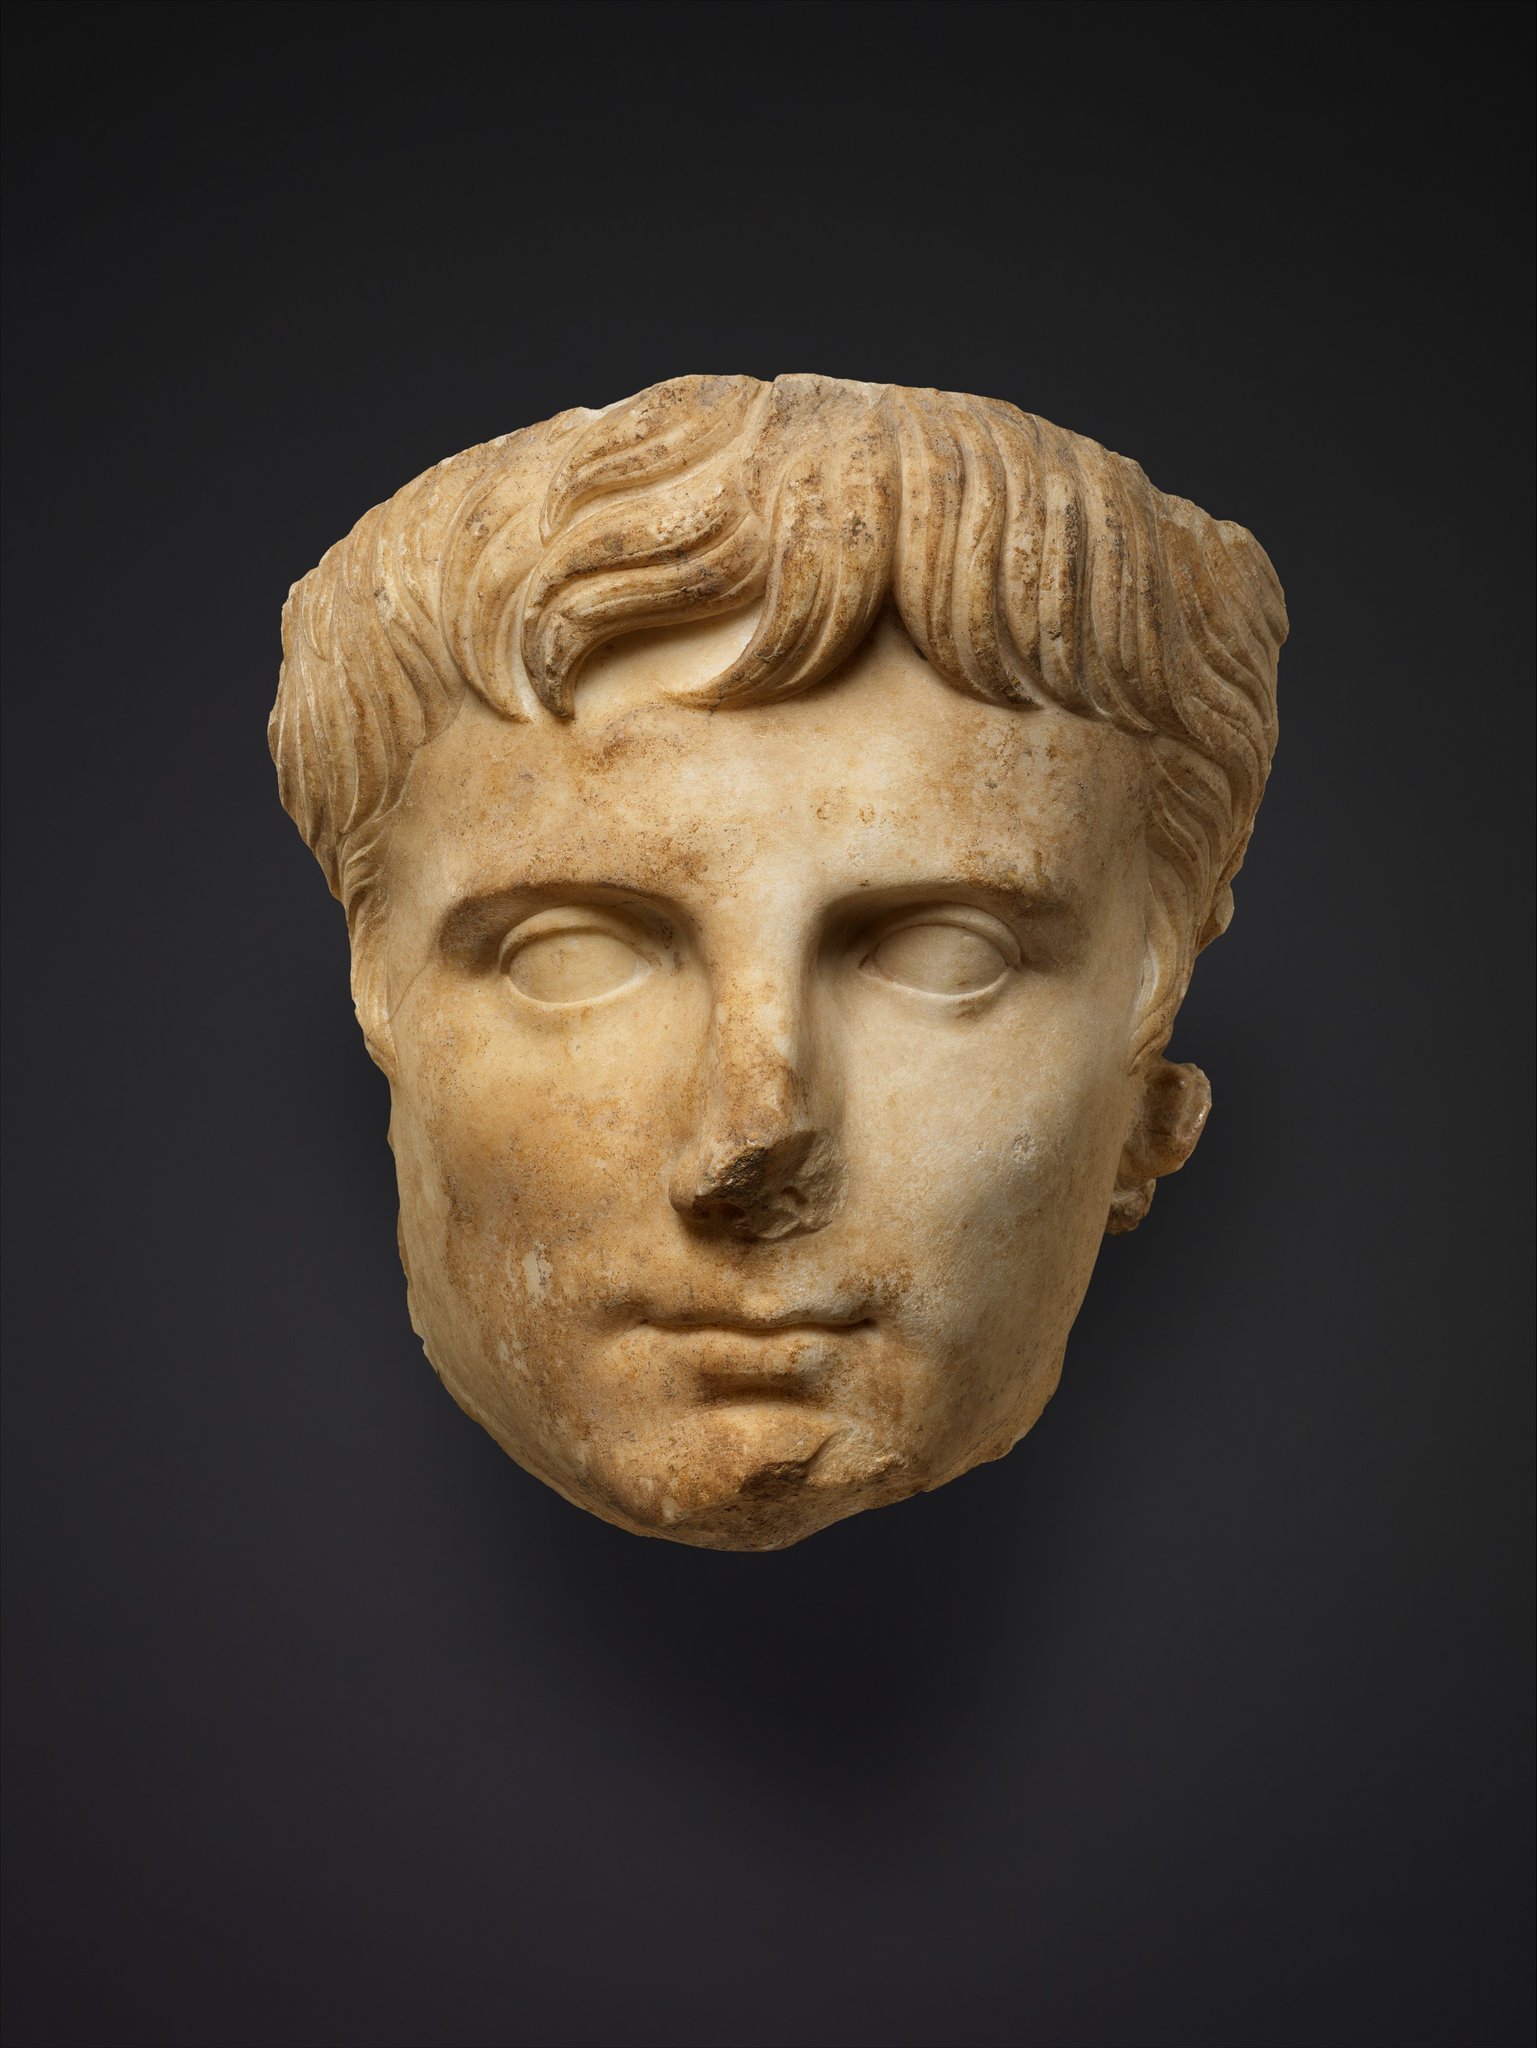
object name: portrait head of the emperor augustus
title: Marble portrait of the emperor Augustus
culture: roman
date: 14-37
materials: marble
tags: emperor augustus,men,portraits